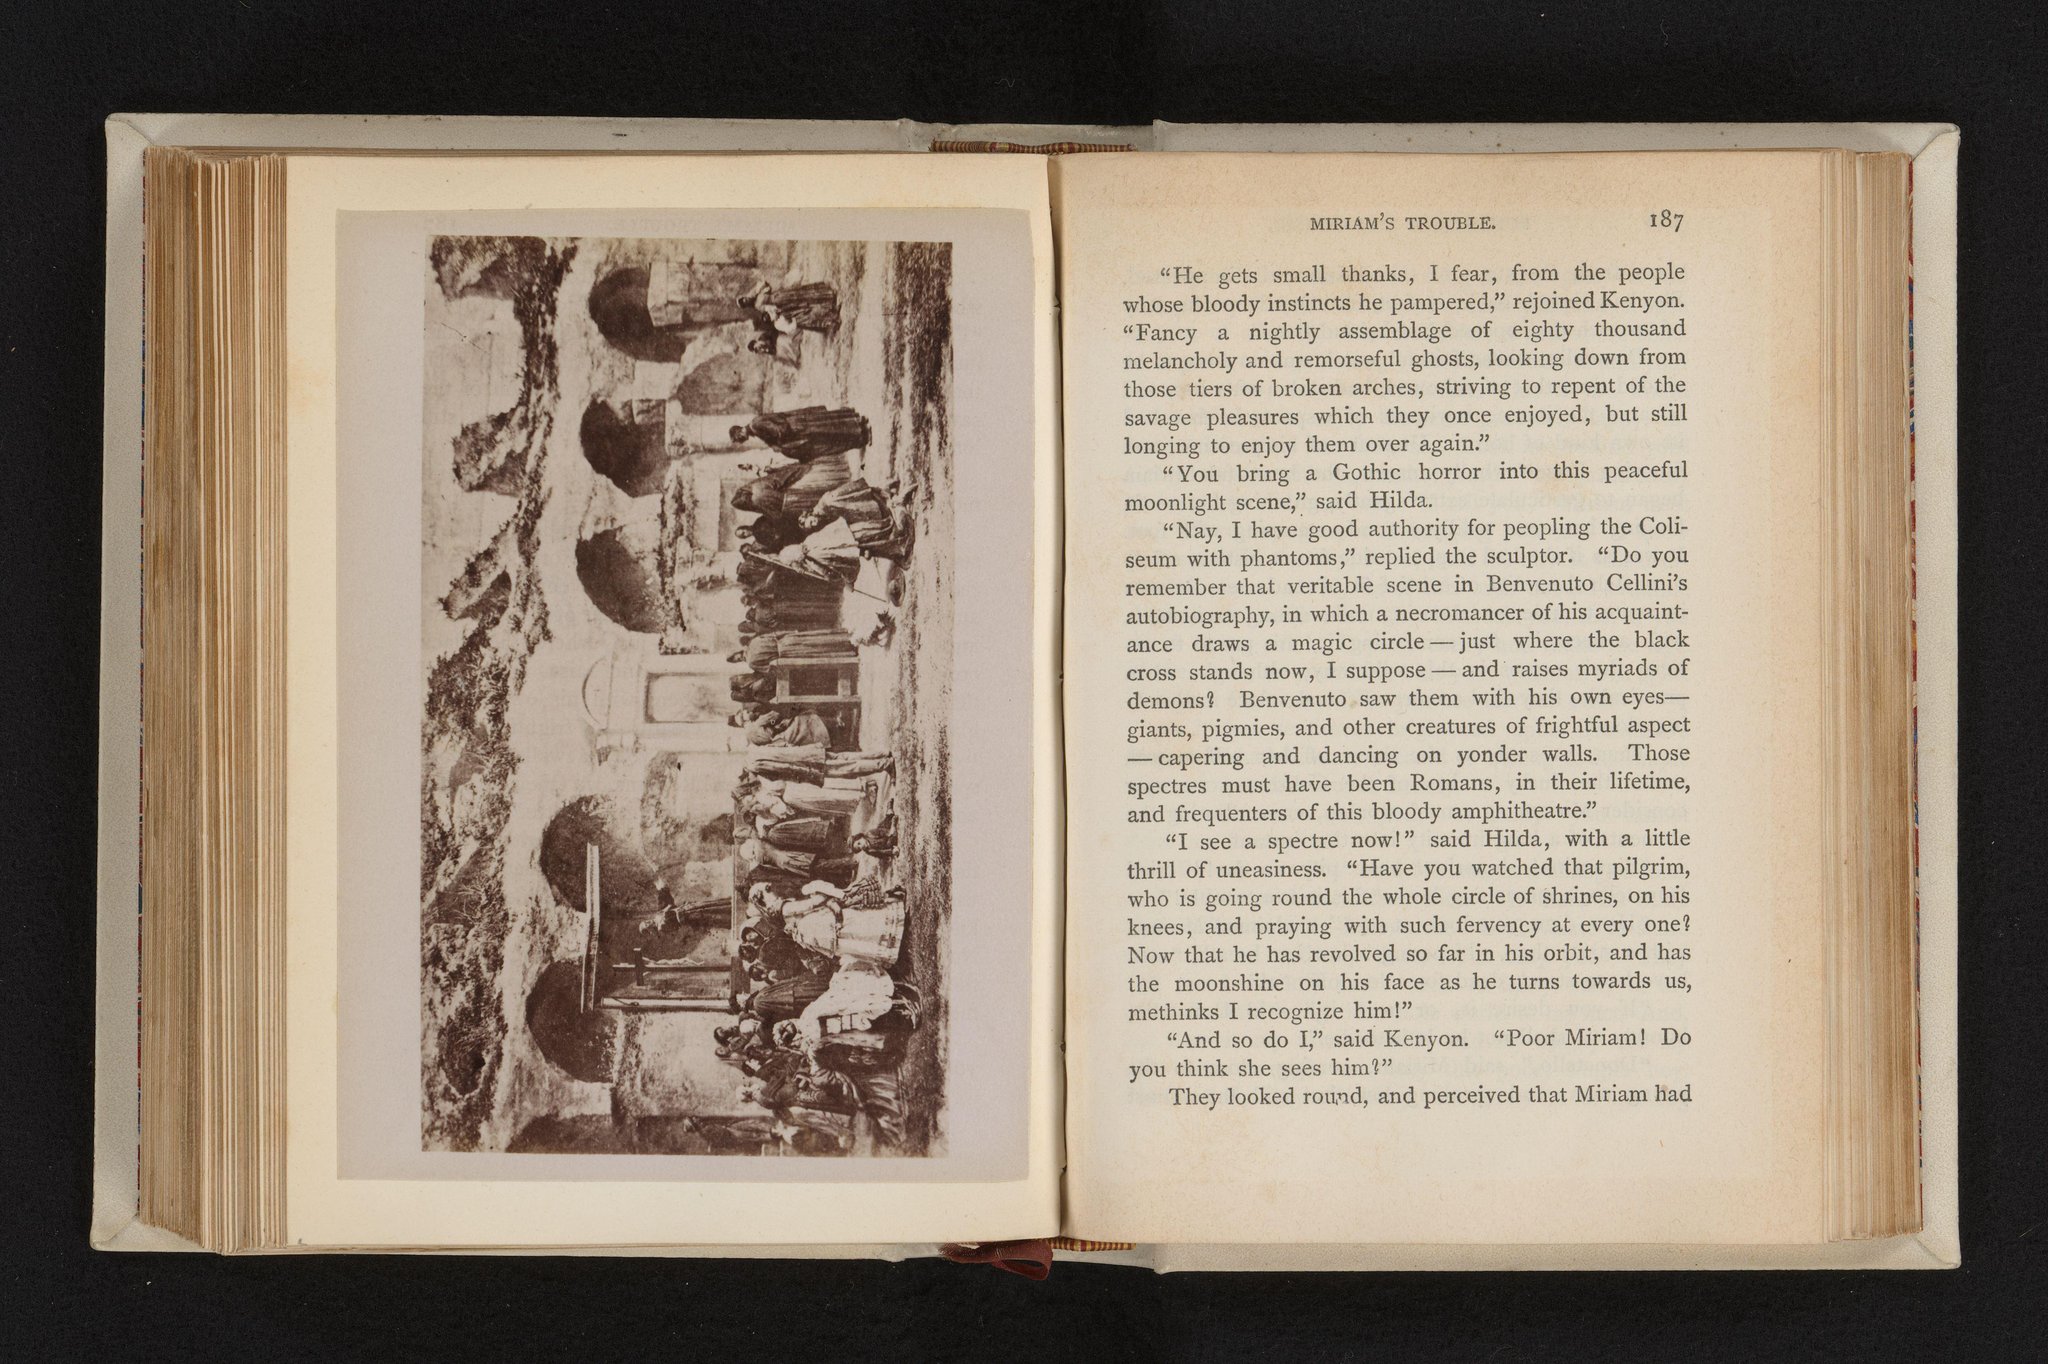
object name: photograph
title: Fotoreproductie van een scene met mensen voor een podium met een prediker vermoedelijk in het Colosseum in Rome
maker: Anonymous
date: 1850-1860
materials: photographic support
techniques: albumen print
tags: preaching (in general)